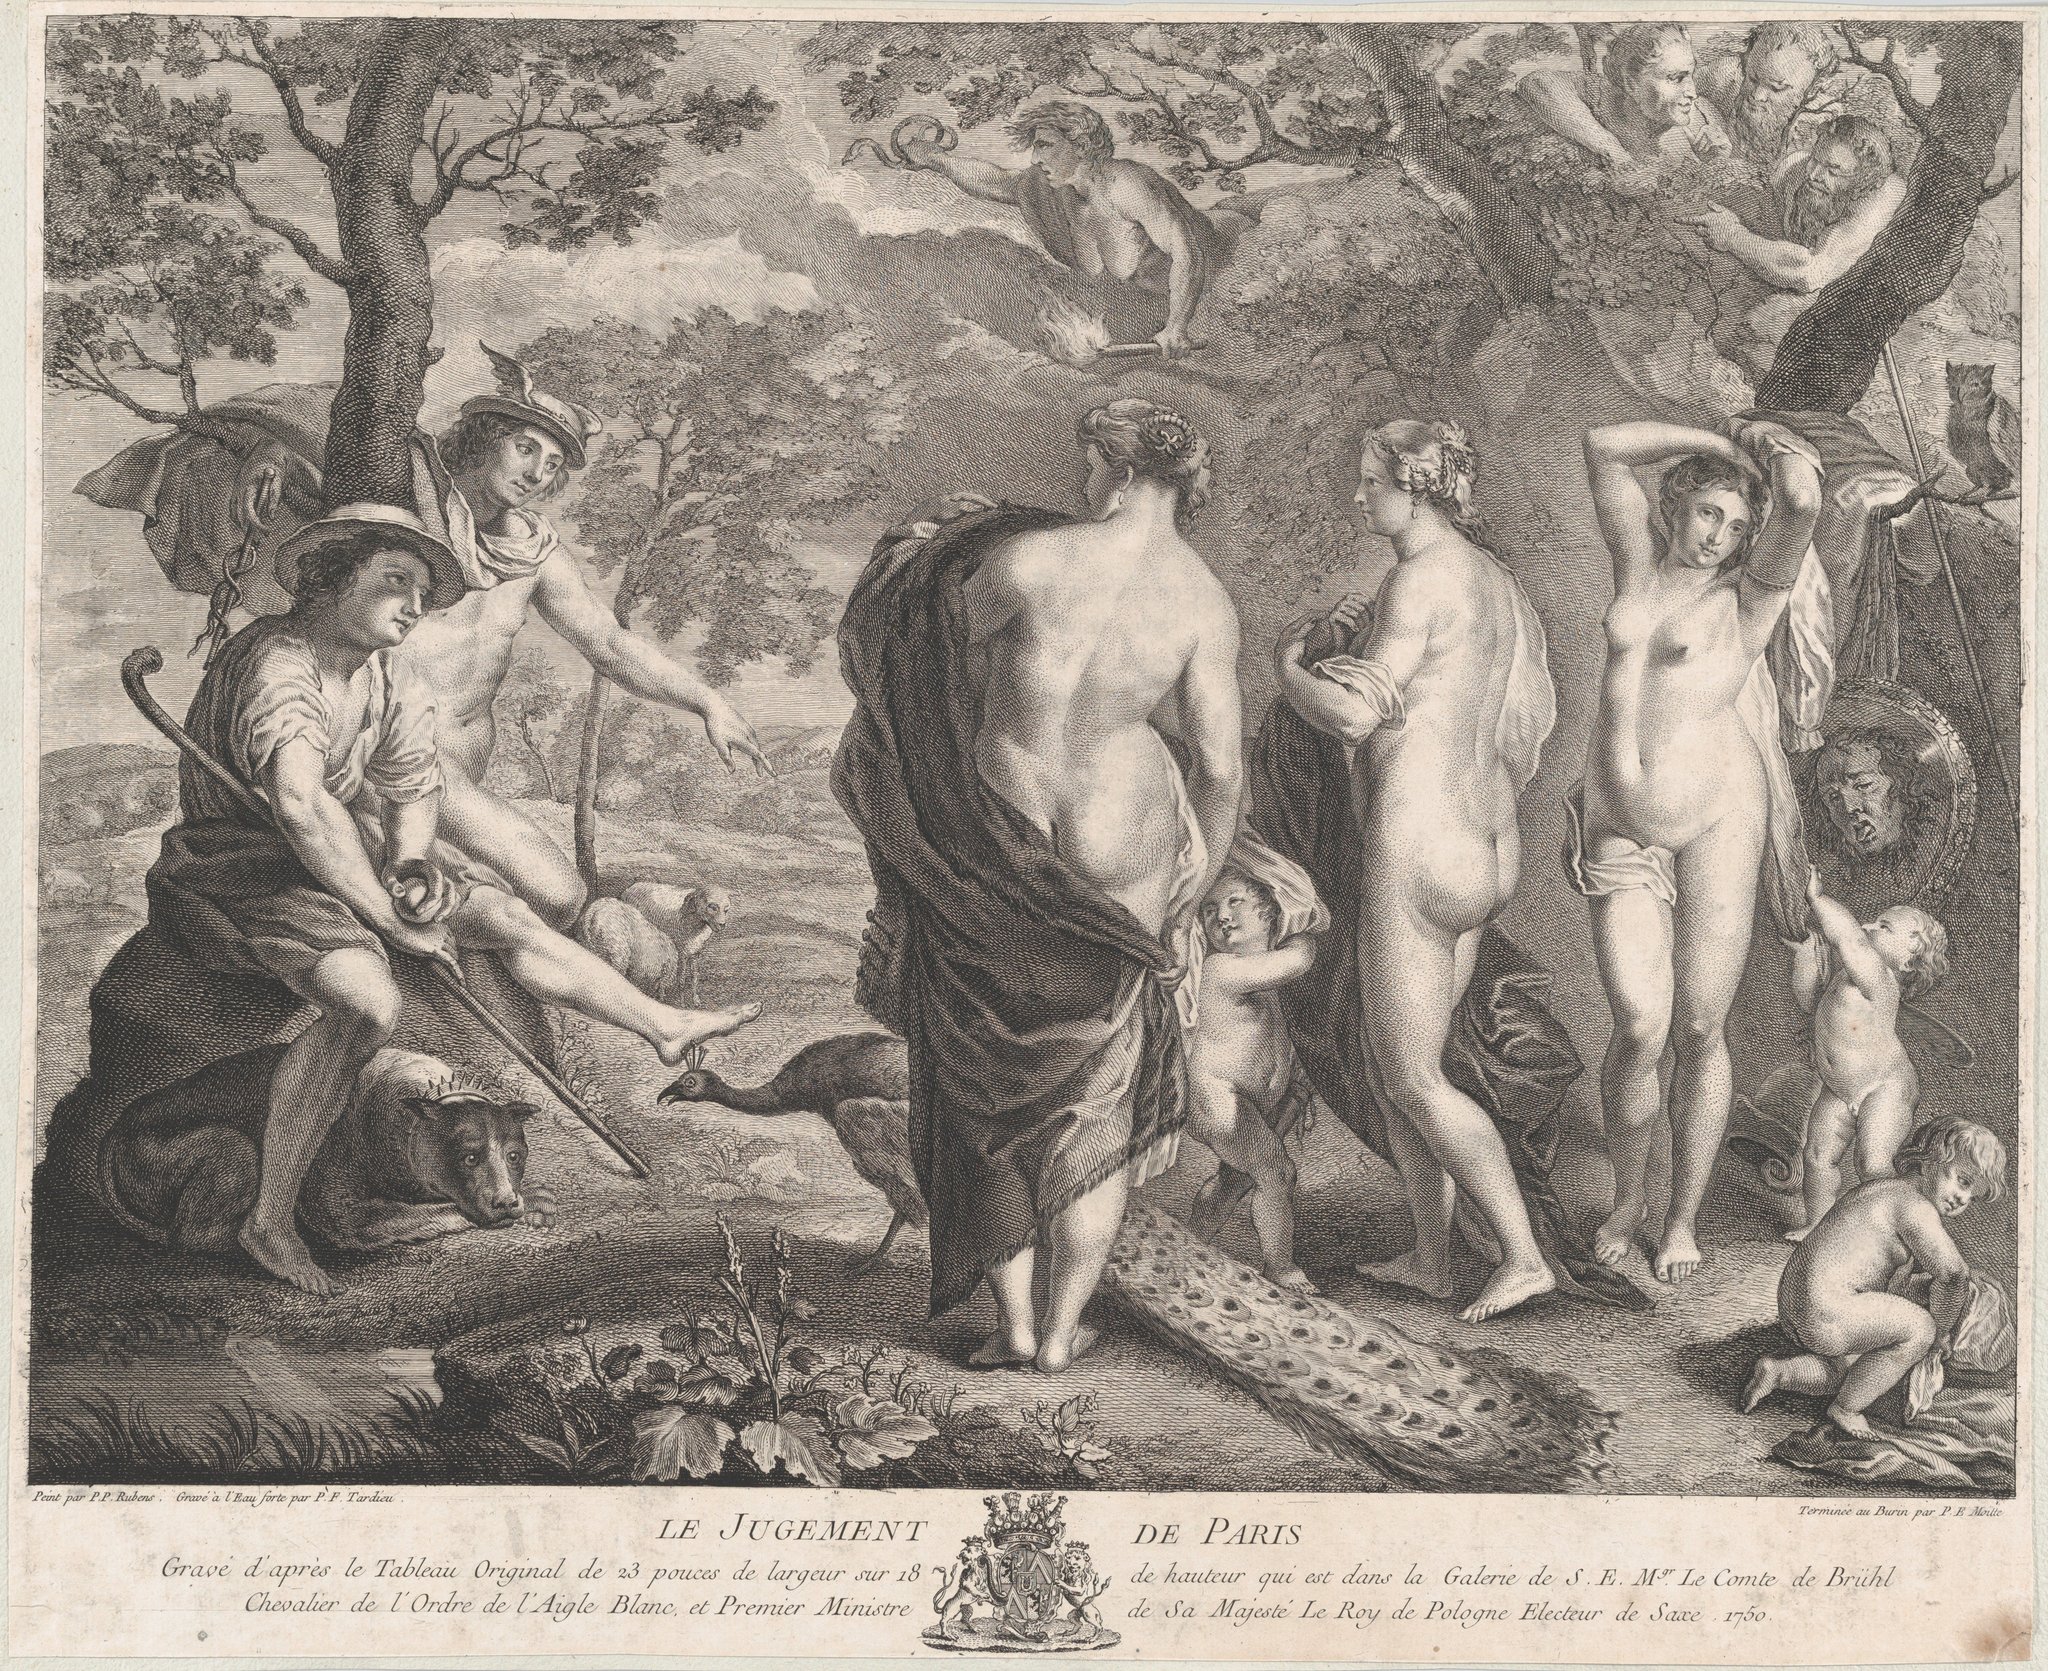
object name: print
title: The Judgment of Paris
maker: pierre françois tardieu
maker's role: etcher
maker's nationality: french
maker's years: 1711-1771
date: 1750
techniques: engraving, etching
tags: female nudes,juno,minerva,venus,peacocks,dogs,paris